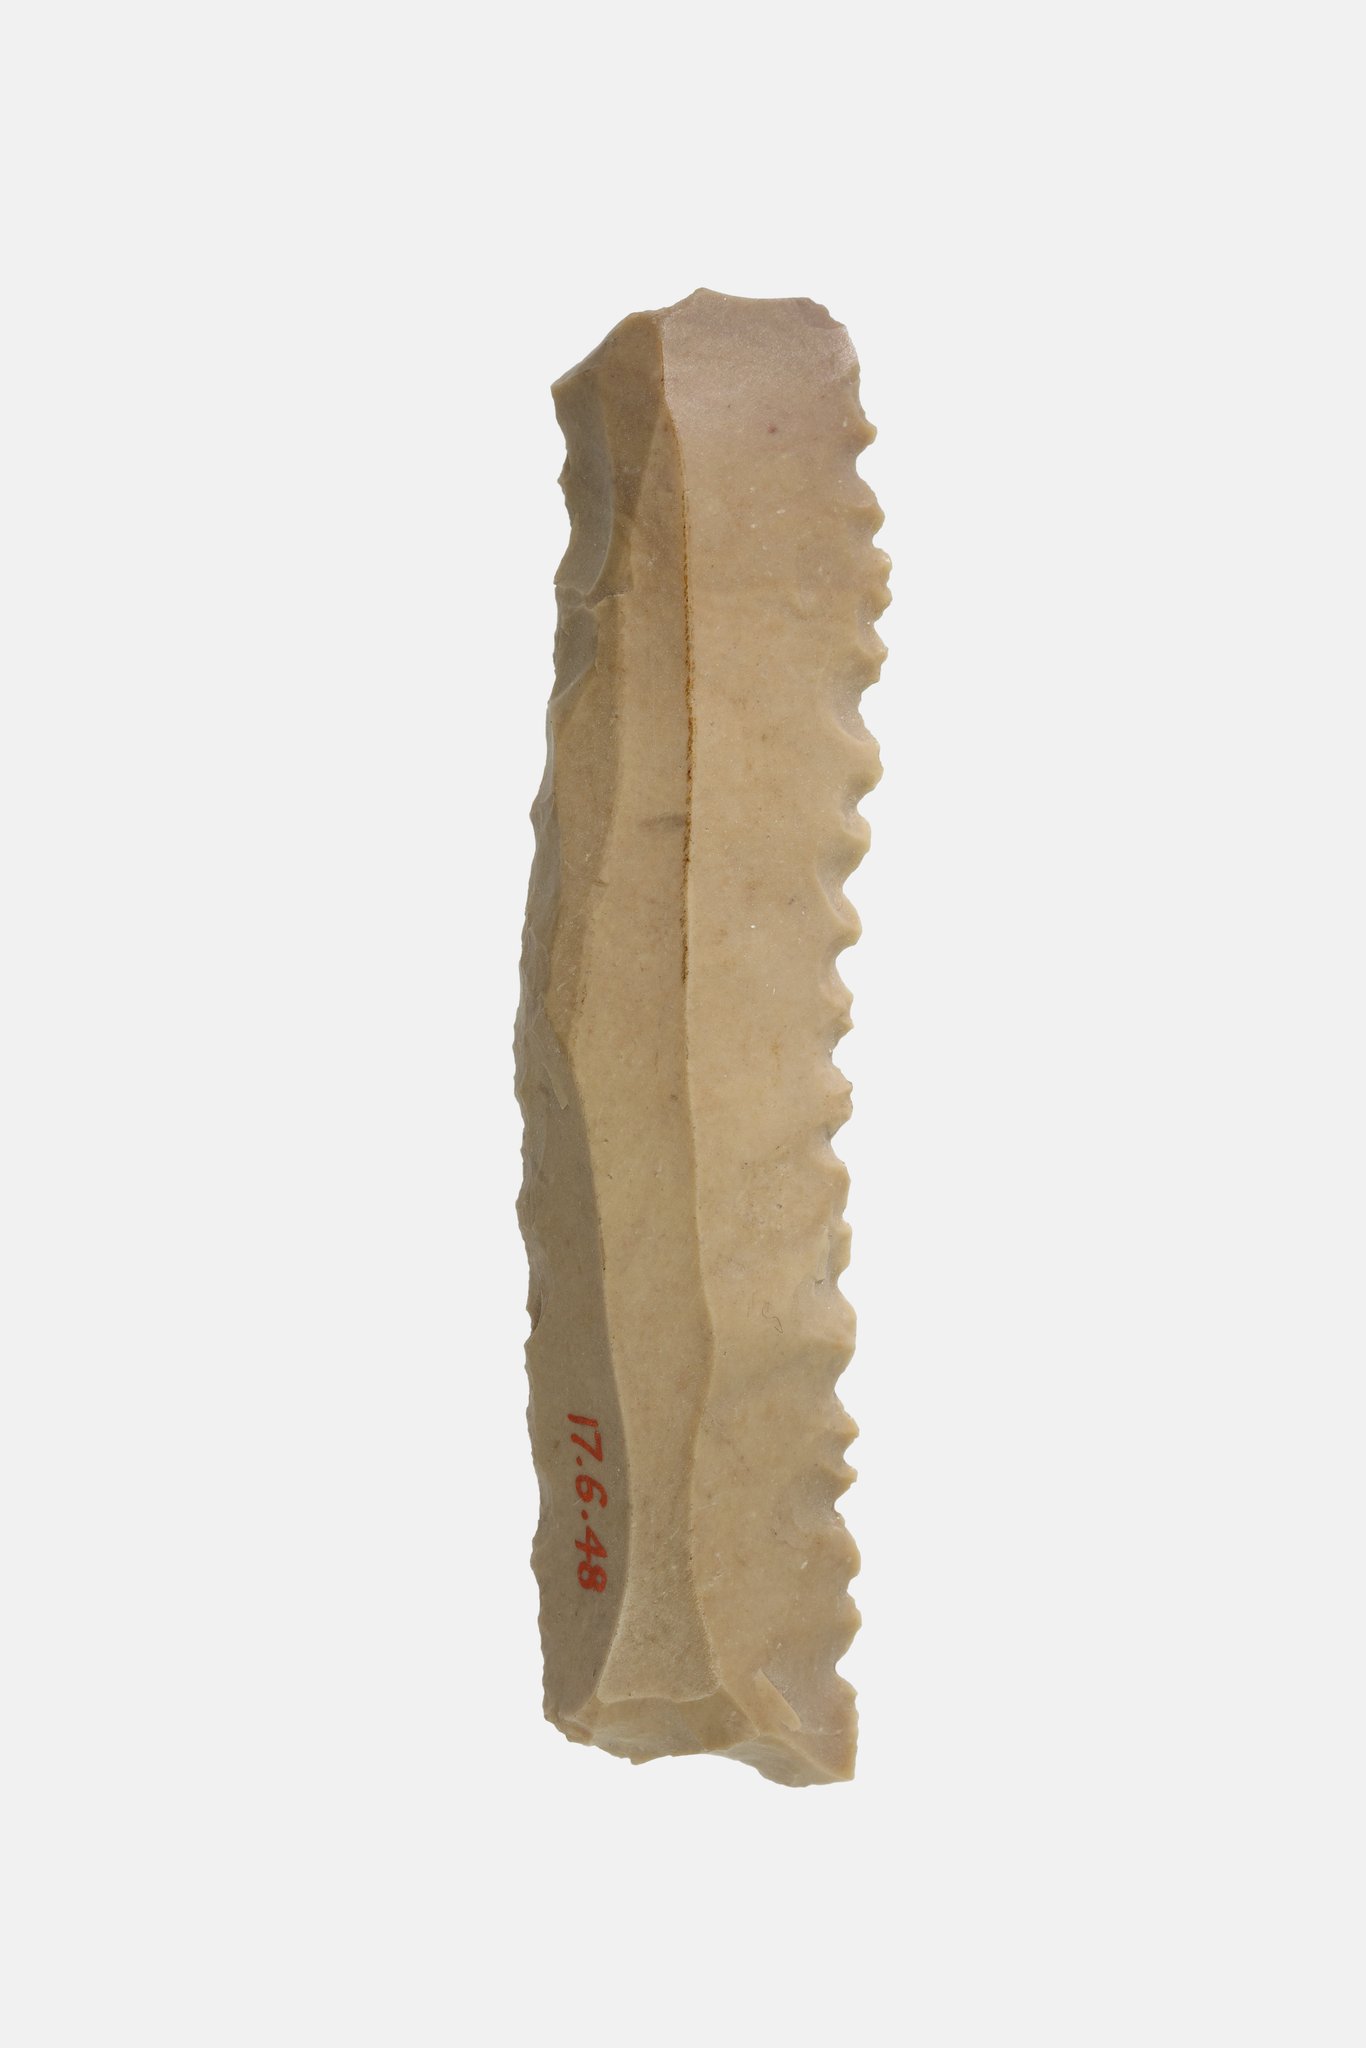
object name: sickle, insert, denticulate, backed, bi truncated, blade, tool, element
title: Sickle Insert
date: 3100-2650 BCE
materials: stone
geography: northern upper egypt